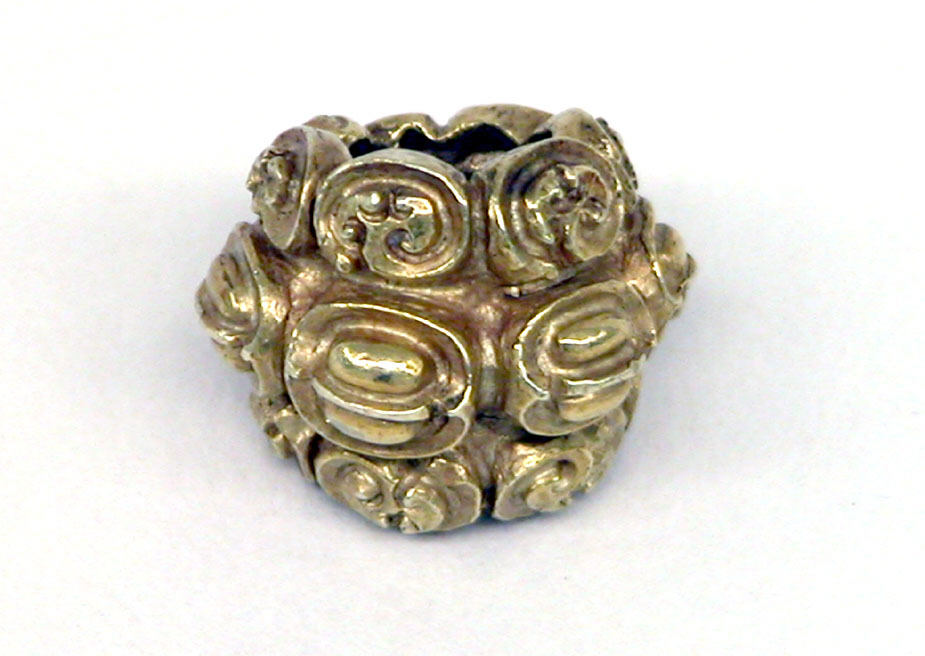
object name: fastener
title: Weighted Fastener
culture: indonesian, javanese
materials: gold